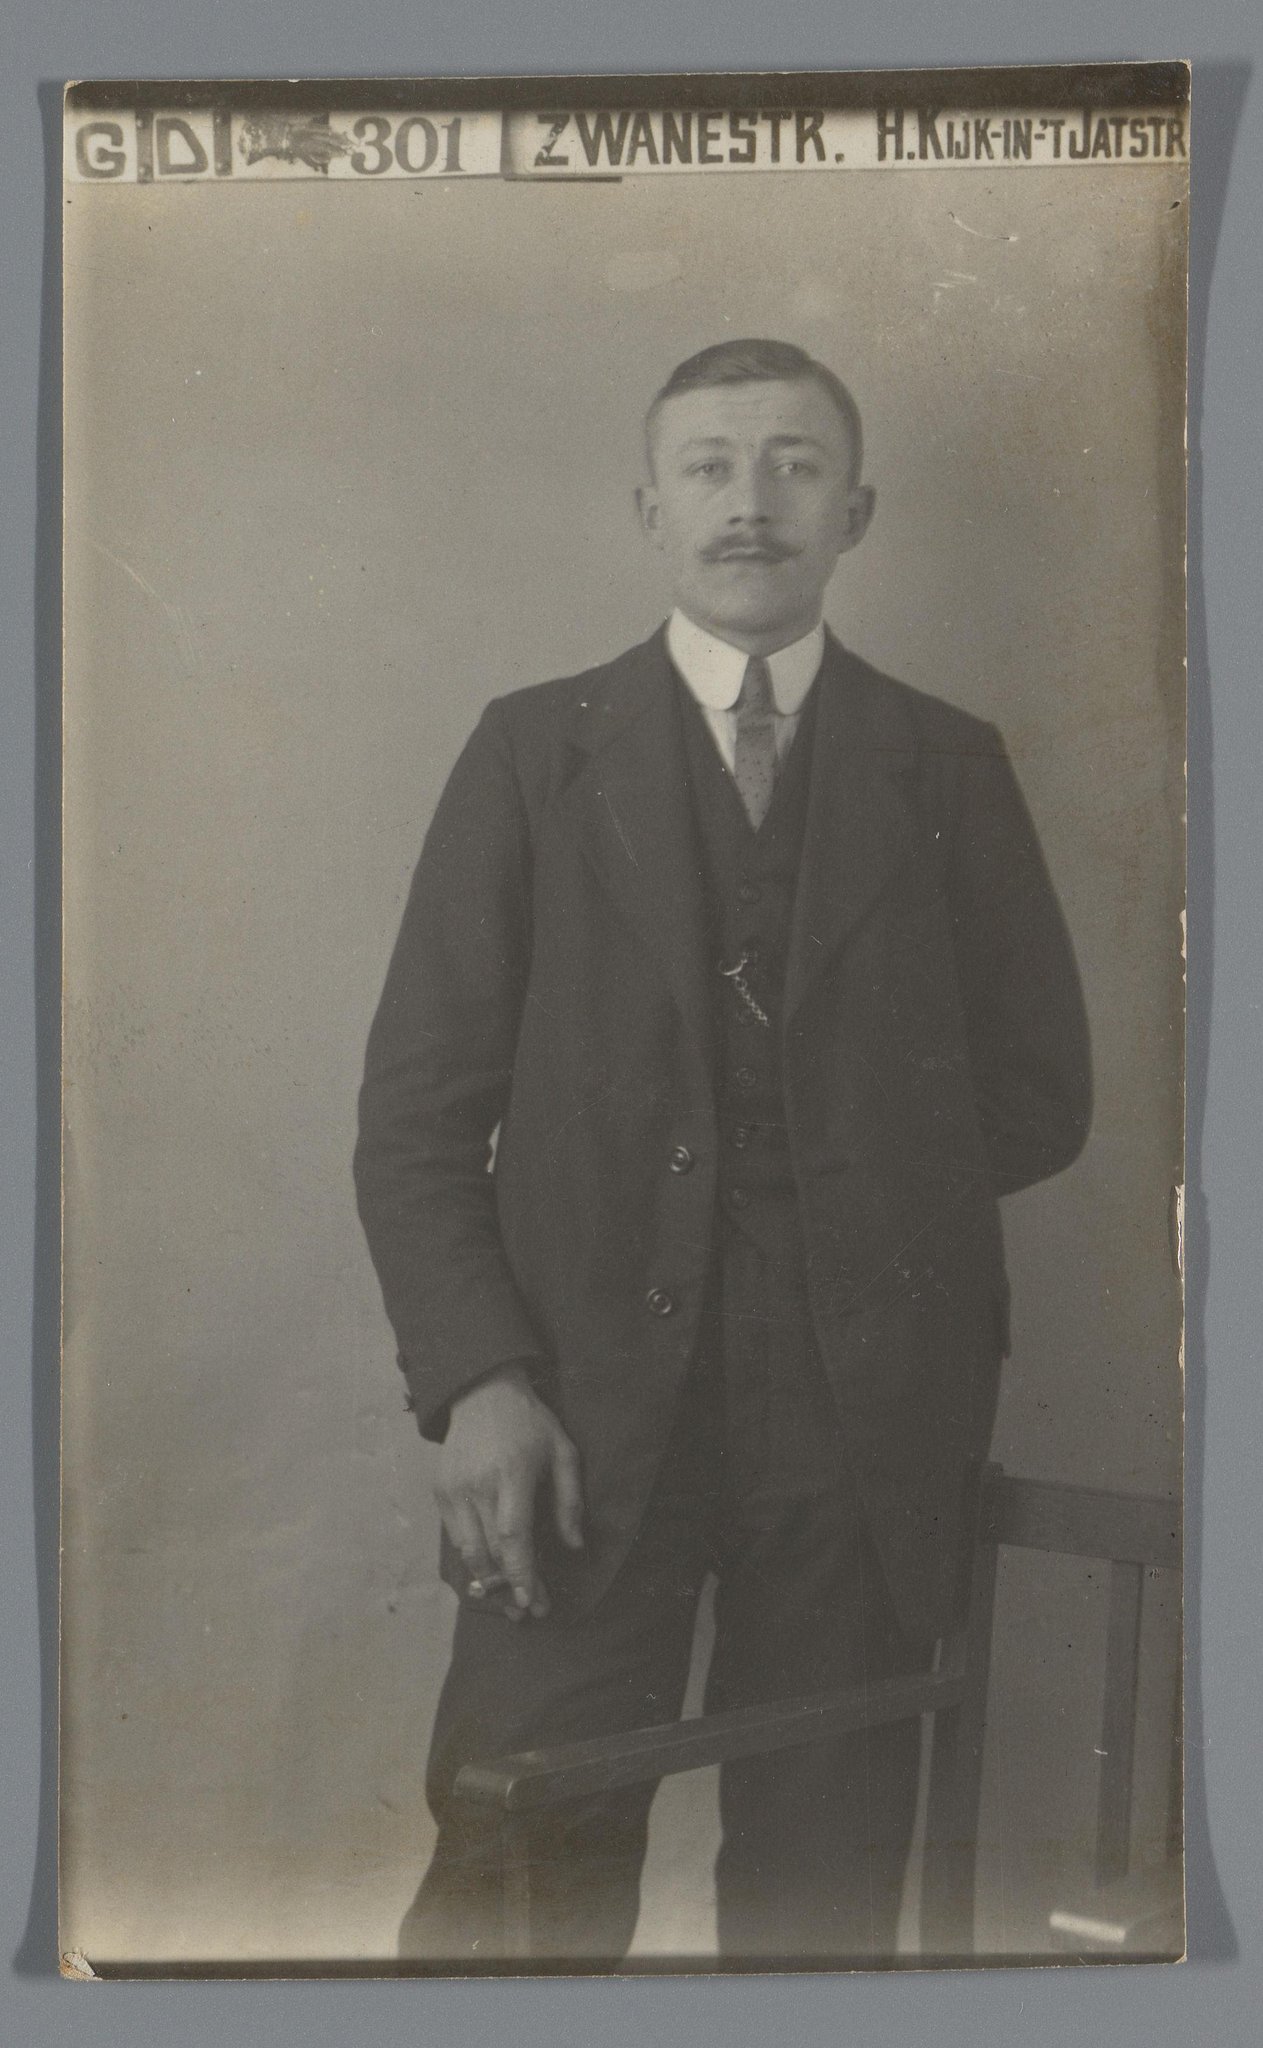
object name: snapshot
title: Portret van een man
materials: photographic support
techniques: gelatin silver print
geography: groningen